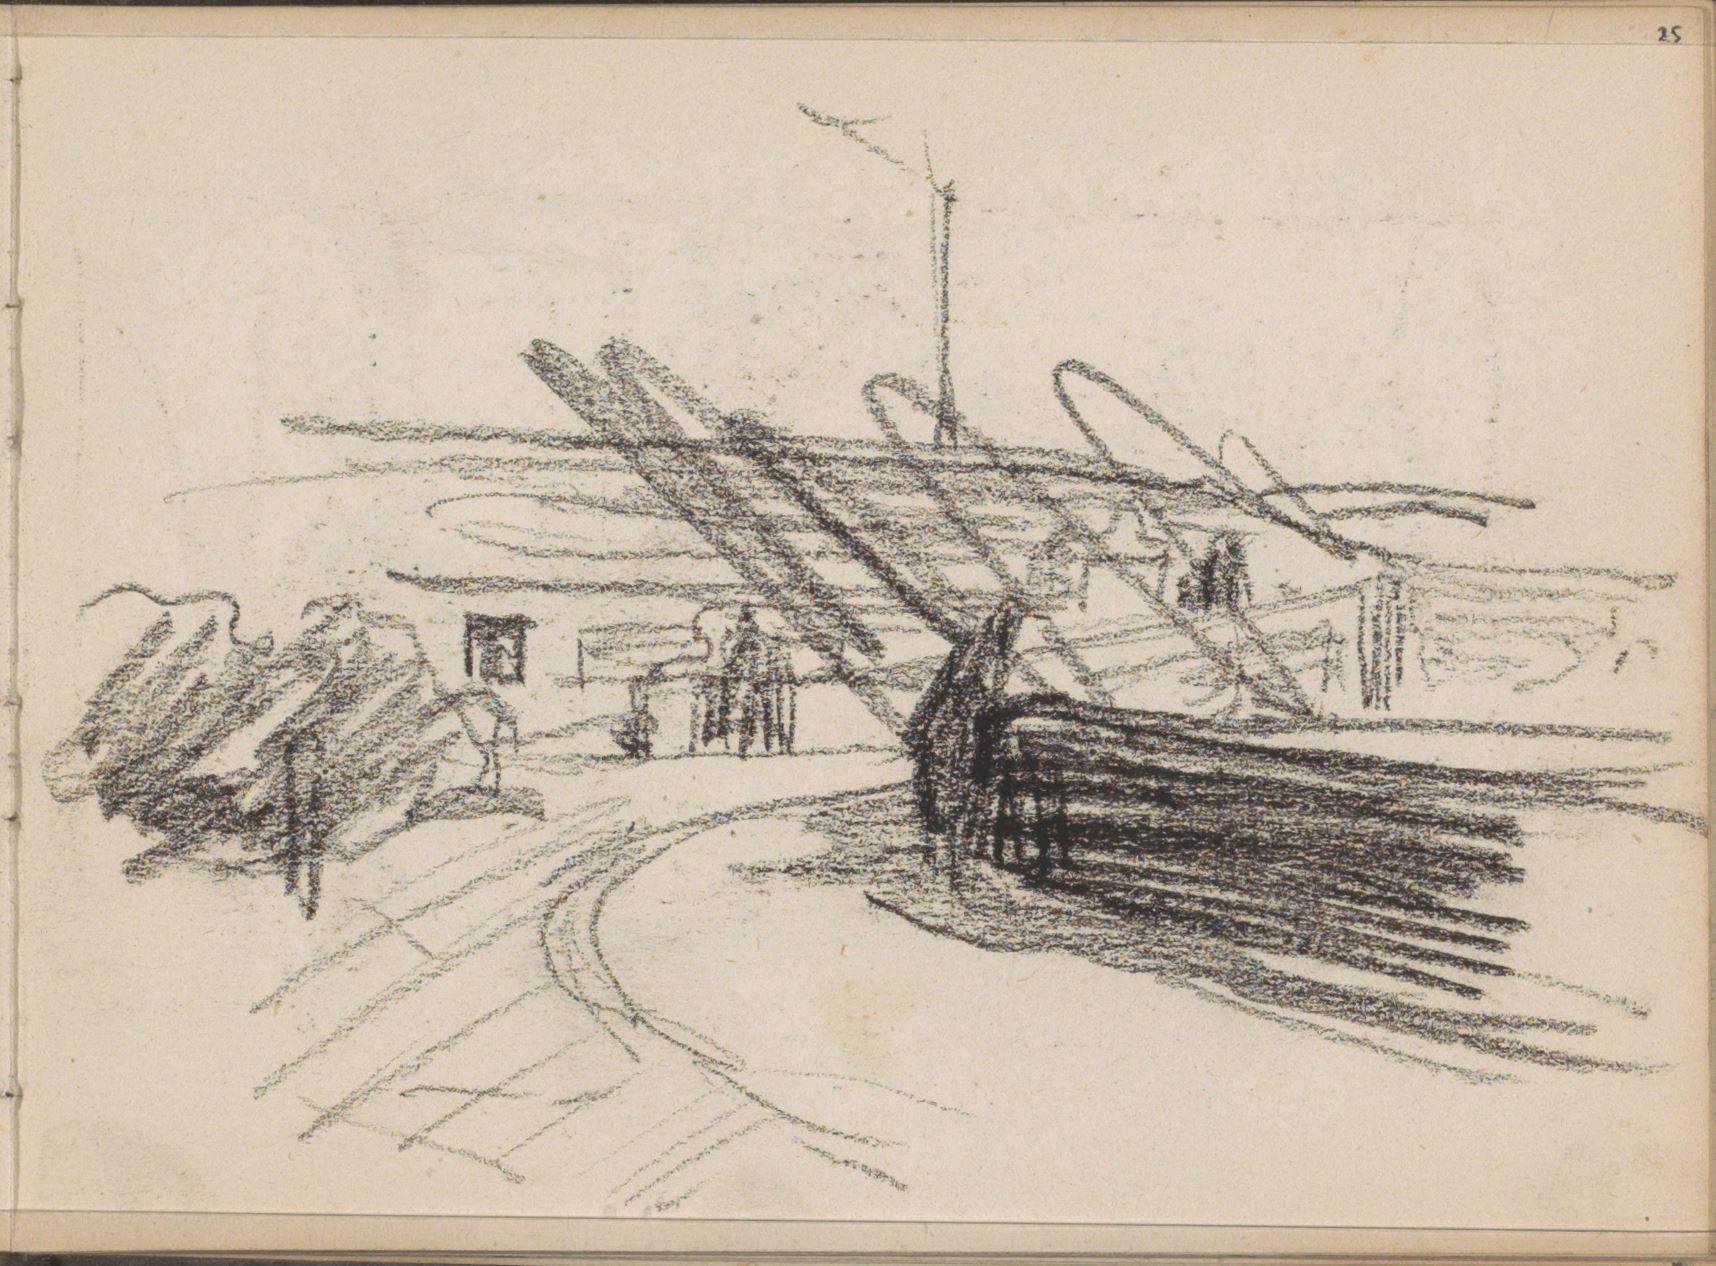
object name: sketchbook leaf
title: Landschap met een weg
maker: marius bauer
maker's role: draughtsman, print maker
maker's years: 1867-1932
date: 1877-1932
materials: chalk, paper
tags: landscapes, road, path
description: Pagina 25 uit een schetsboek met 32 bladen.